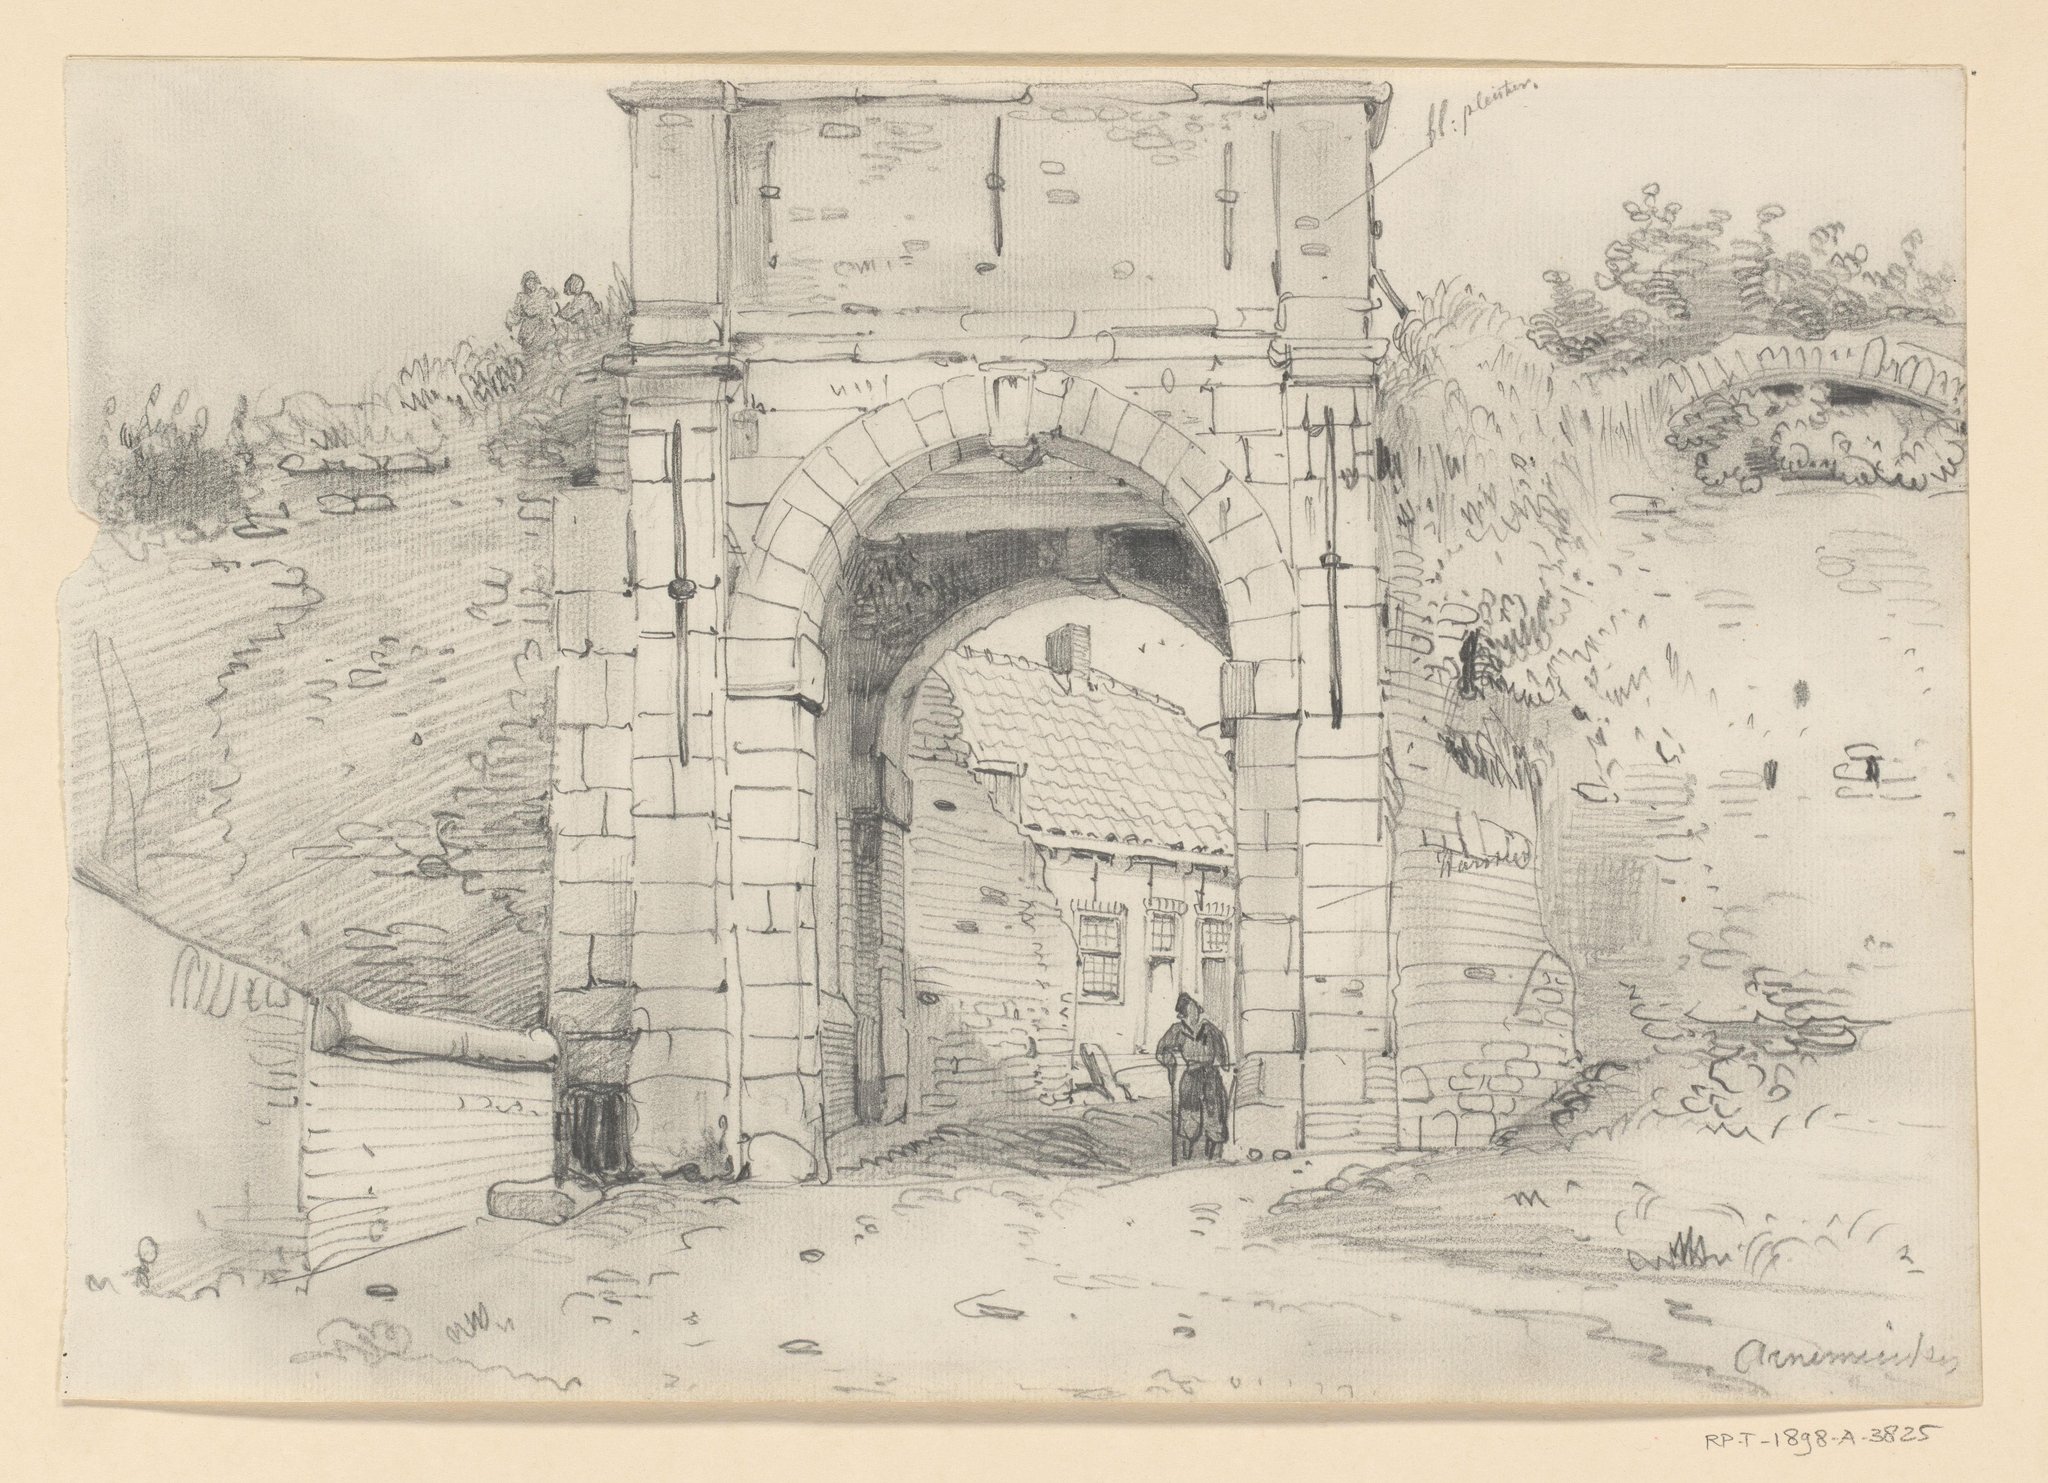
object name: drawing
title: Stadspoort te Arnemuiden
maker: willem anthonie van deventer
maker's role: draughtsman, painter, print maker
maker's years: 1824-1893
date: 1834-1893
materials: paper, pencil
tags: city-gate